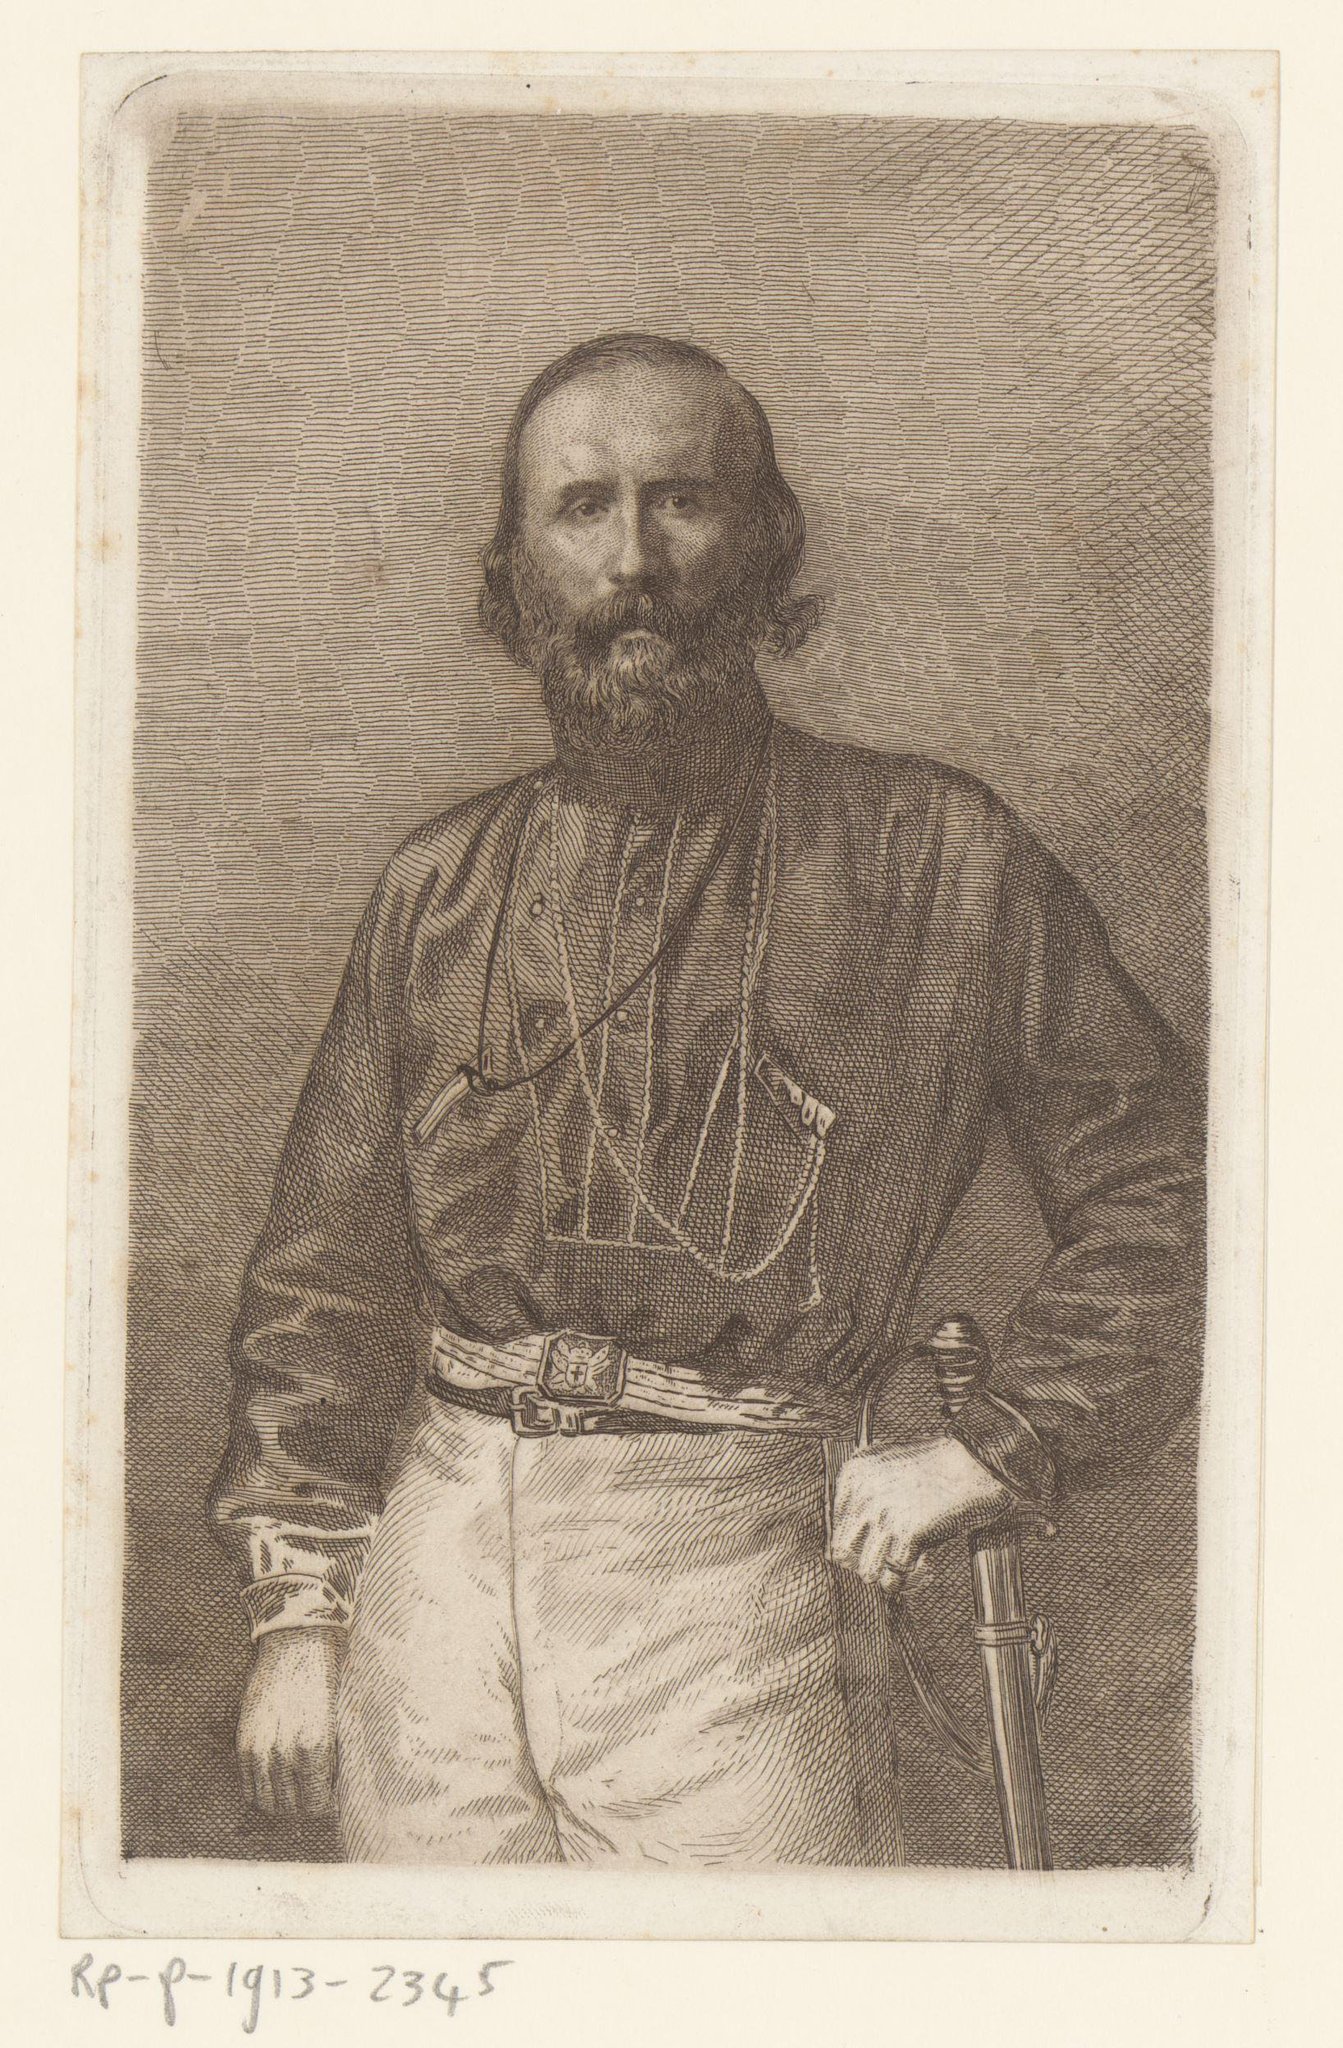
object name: print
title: Portret van Giuseppe Garibaldi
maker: georg otto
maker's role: print maker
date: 1822-1899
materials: paper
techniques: etching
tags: historical persons, hacking and thrusting weapons: sword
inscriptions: collector's mark: Lugt 2228, collector's mark: Lugt 1485, collector's mark: Lugt 2228